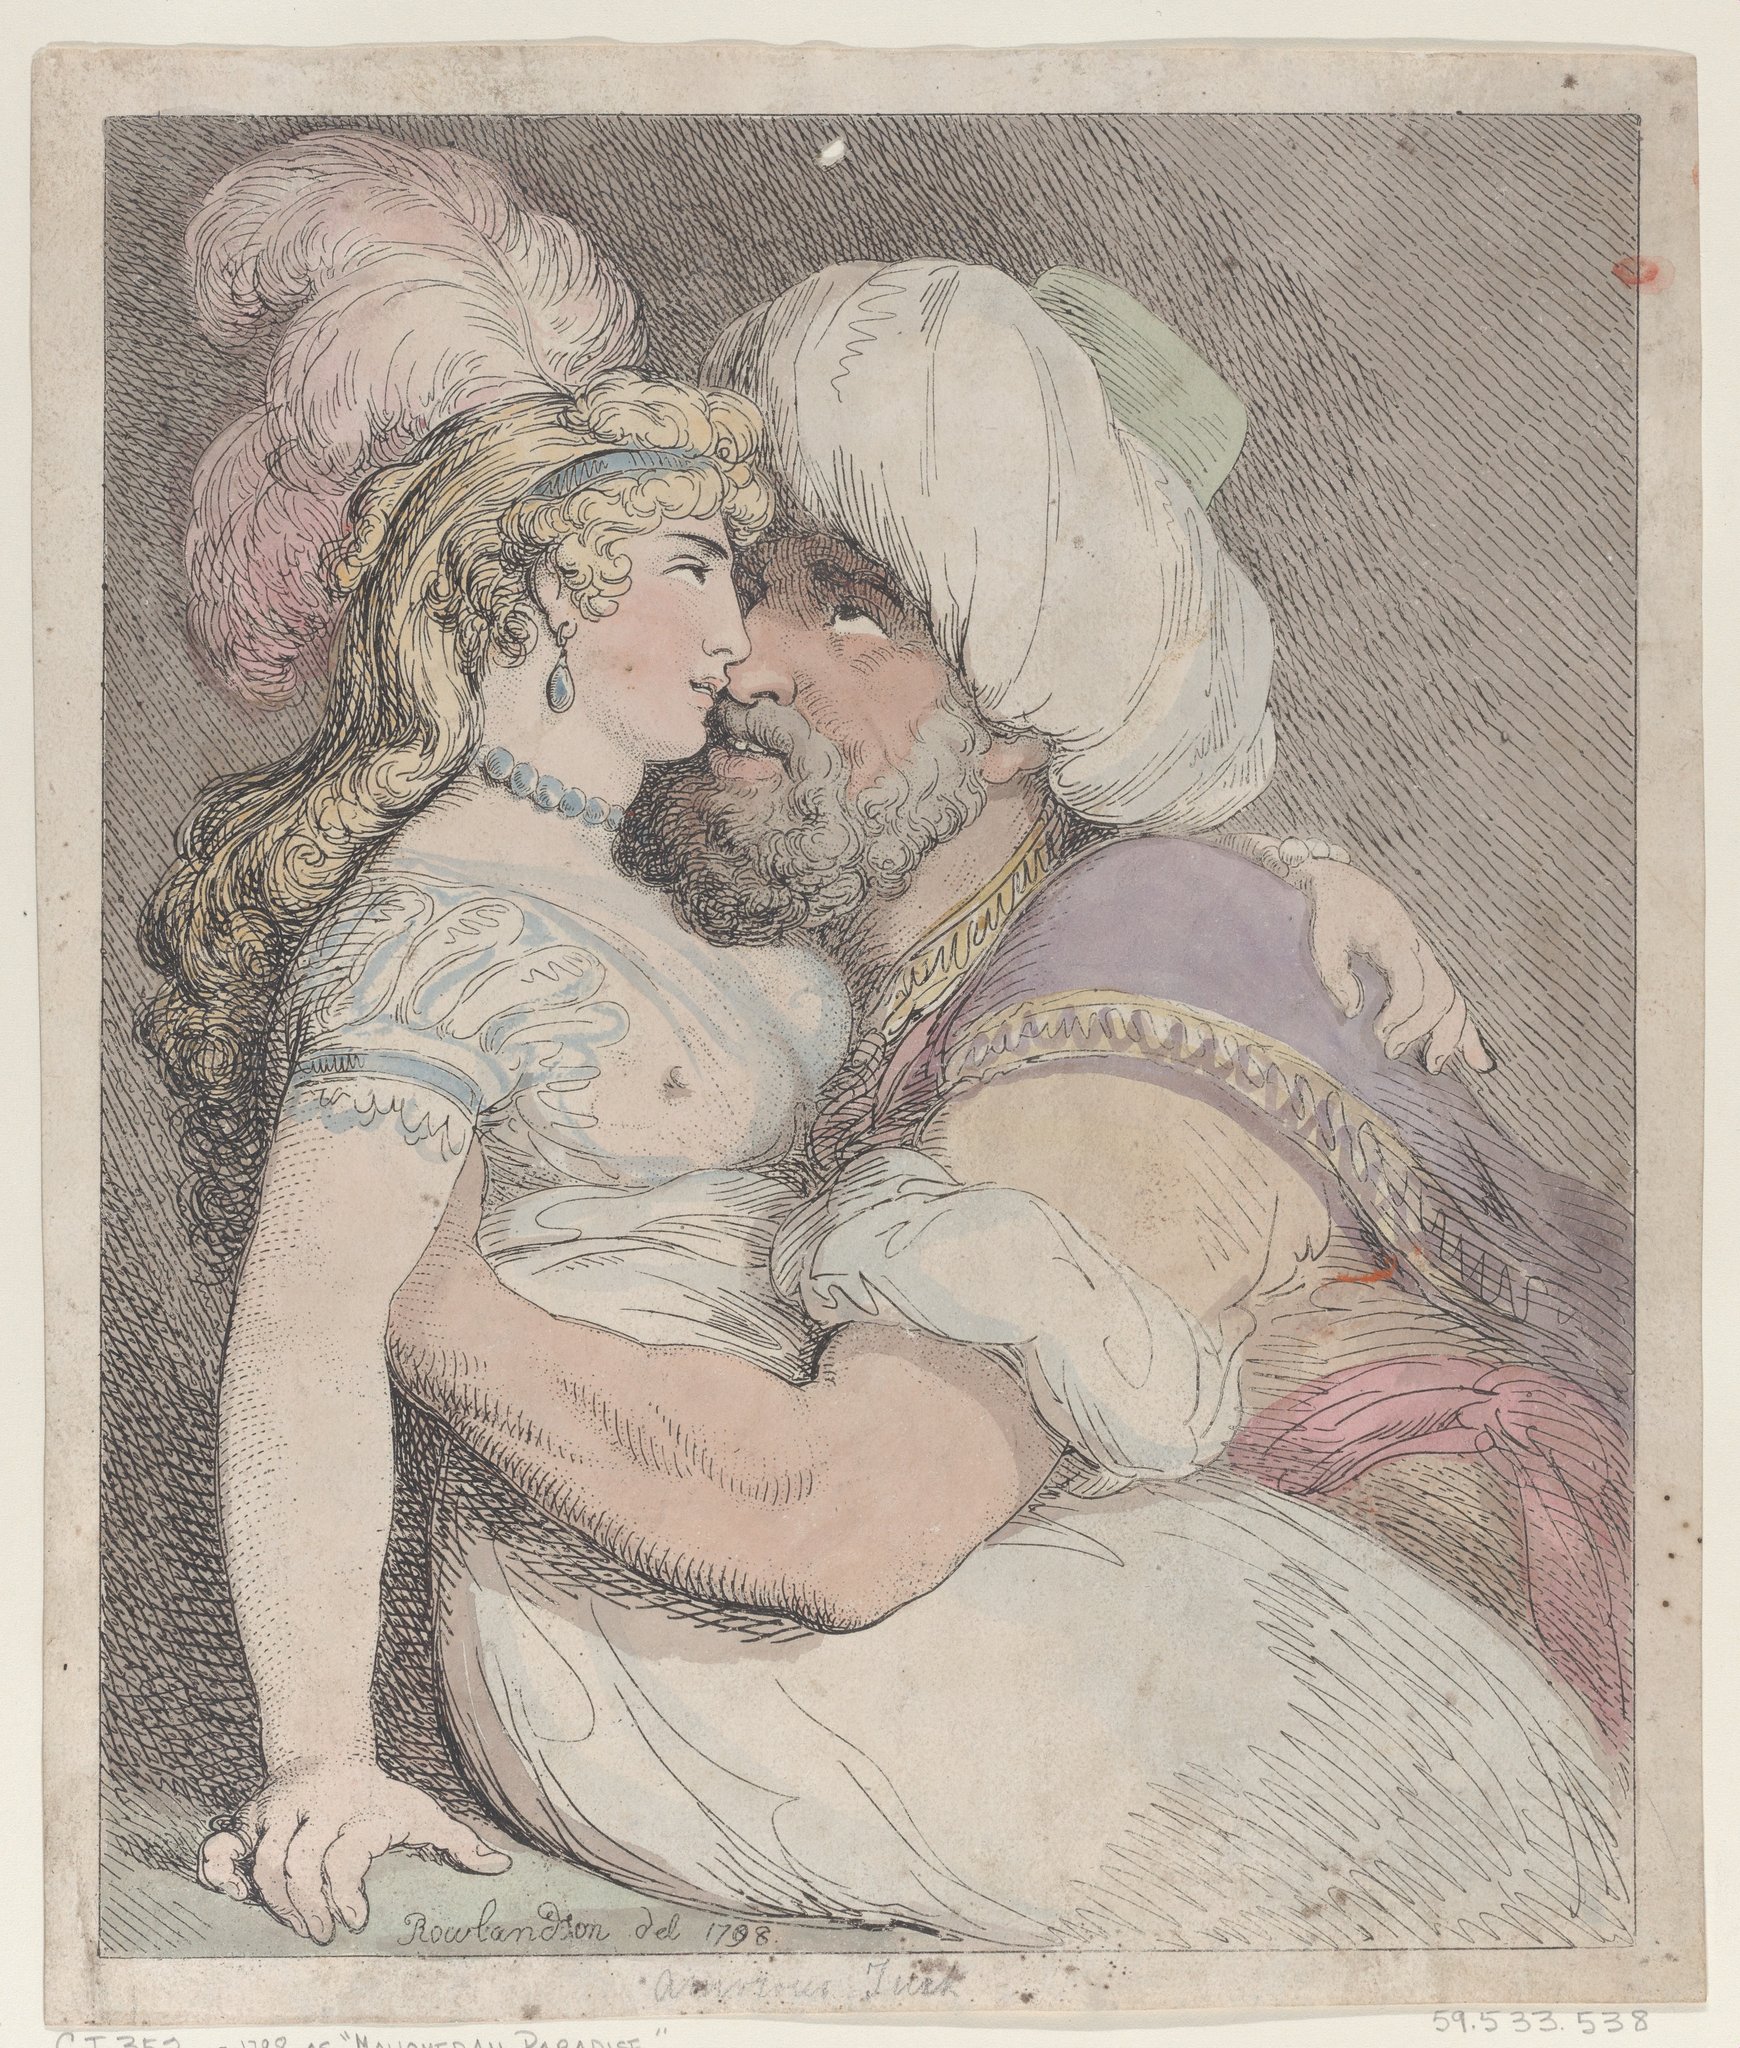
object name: print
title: An Amorous Turk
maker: thomas rowlandson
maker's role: artist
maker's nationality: british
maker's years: 1757-1827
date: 1798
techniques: etching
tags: men,women